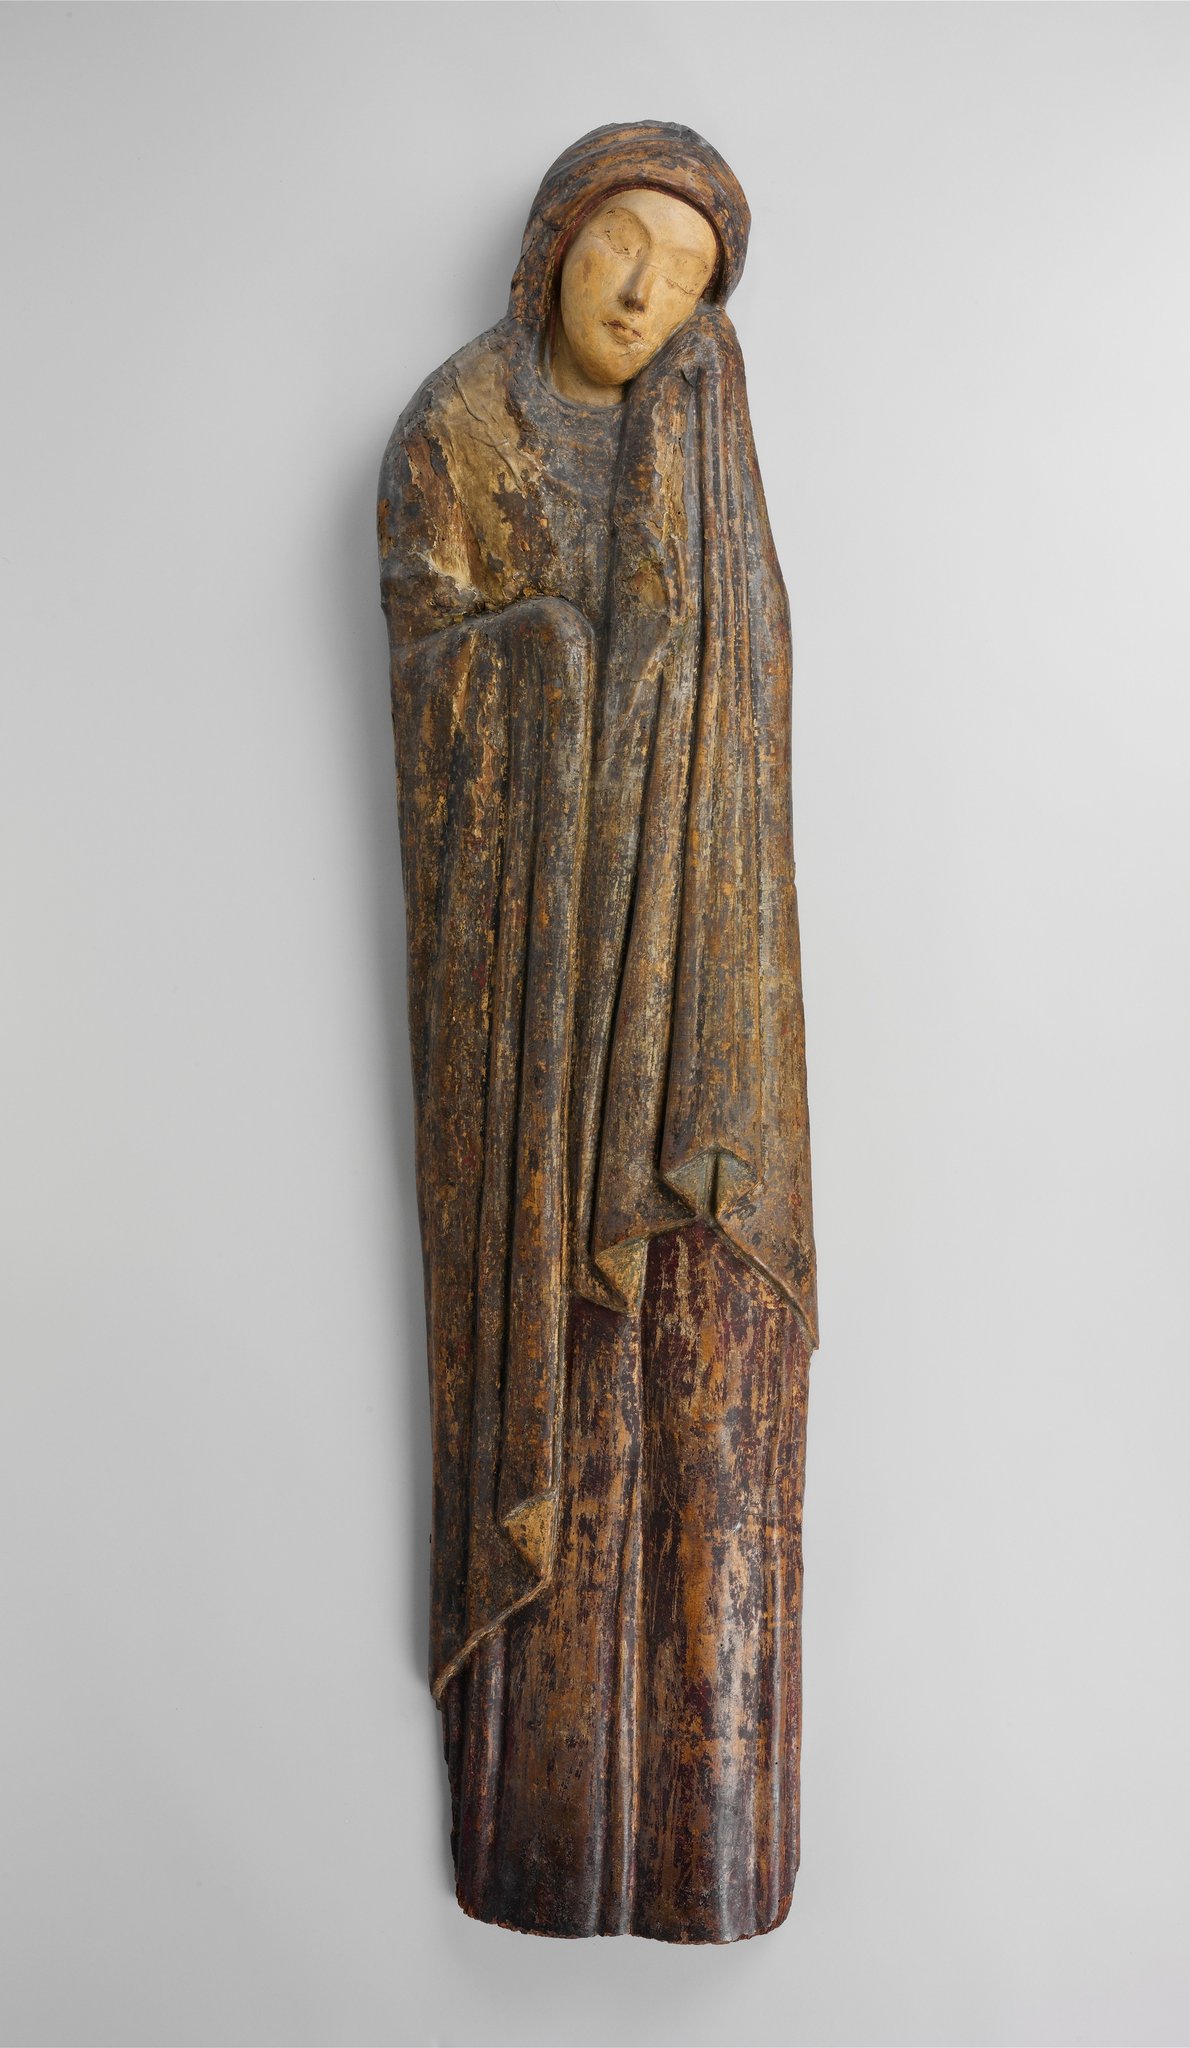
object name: relief statue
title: Mourning Virgin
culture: italian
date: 1234-1266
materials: canvas, foil, gesso, glaze, oil, wood, tin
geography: italy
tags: virgin mary